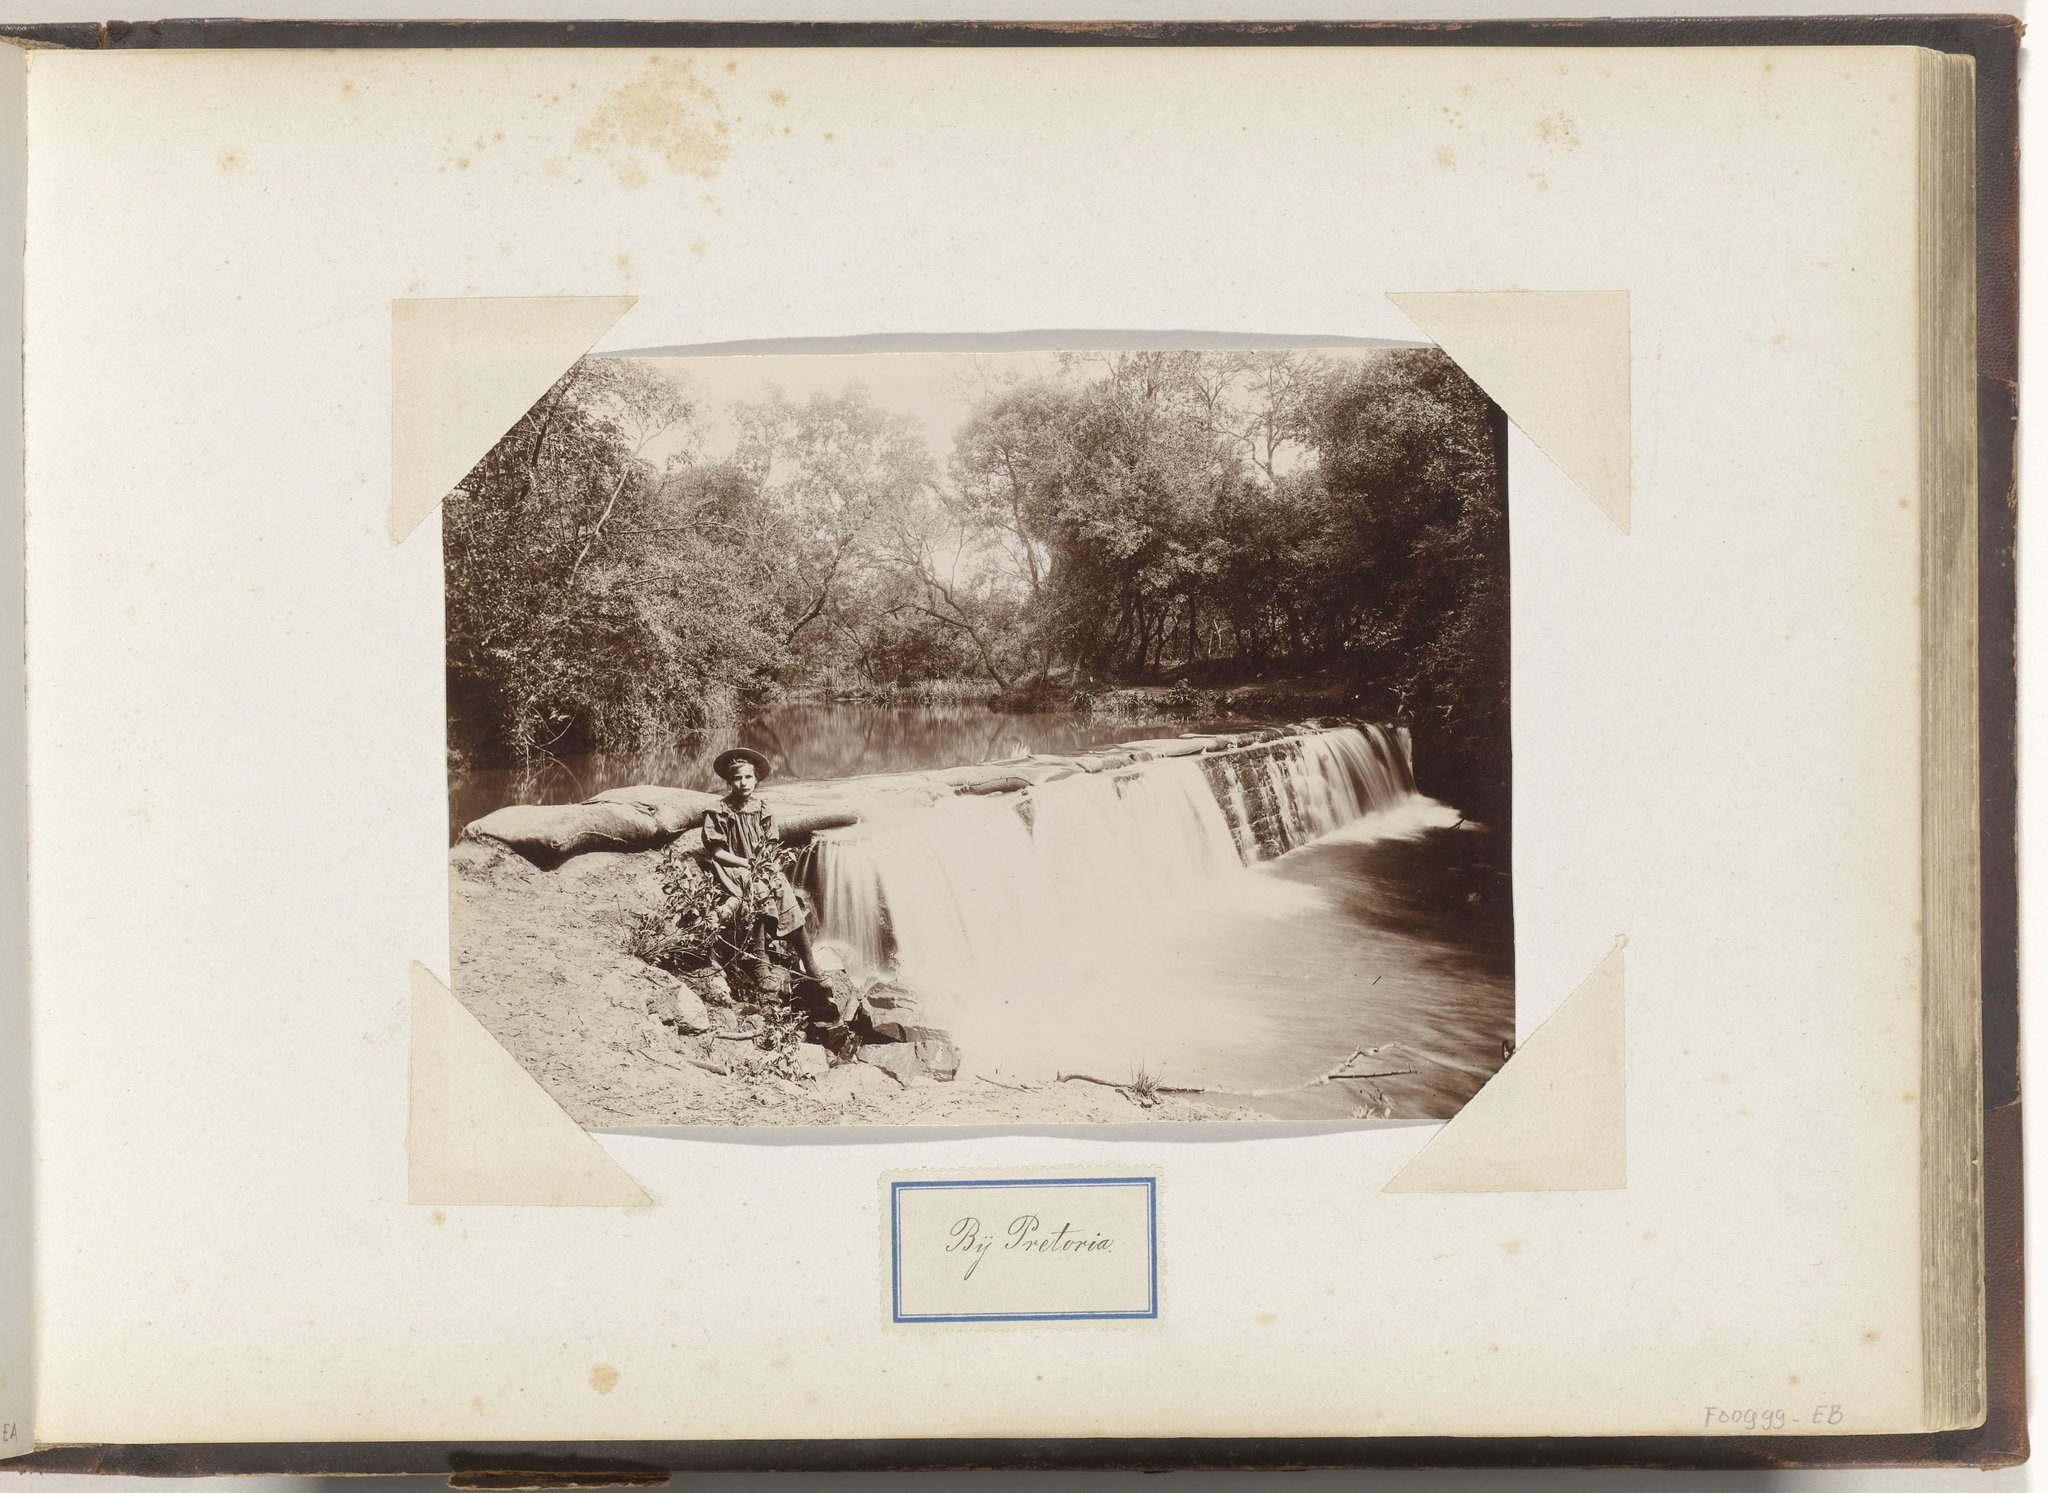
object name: photograph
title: Europees meisje bij een waterval bij Pretoria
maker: Anonymous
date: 1890-1920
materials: paper, photographic support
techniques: daylight paper print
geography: pretoria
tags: waterfall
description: Onderdeel van Album met 191 foto's van een reis naar en door Zuid-Afrika.